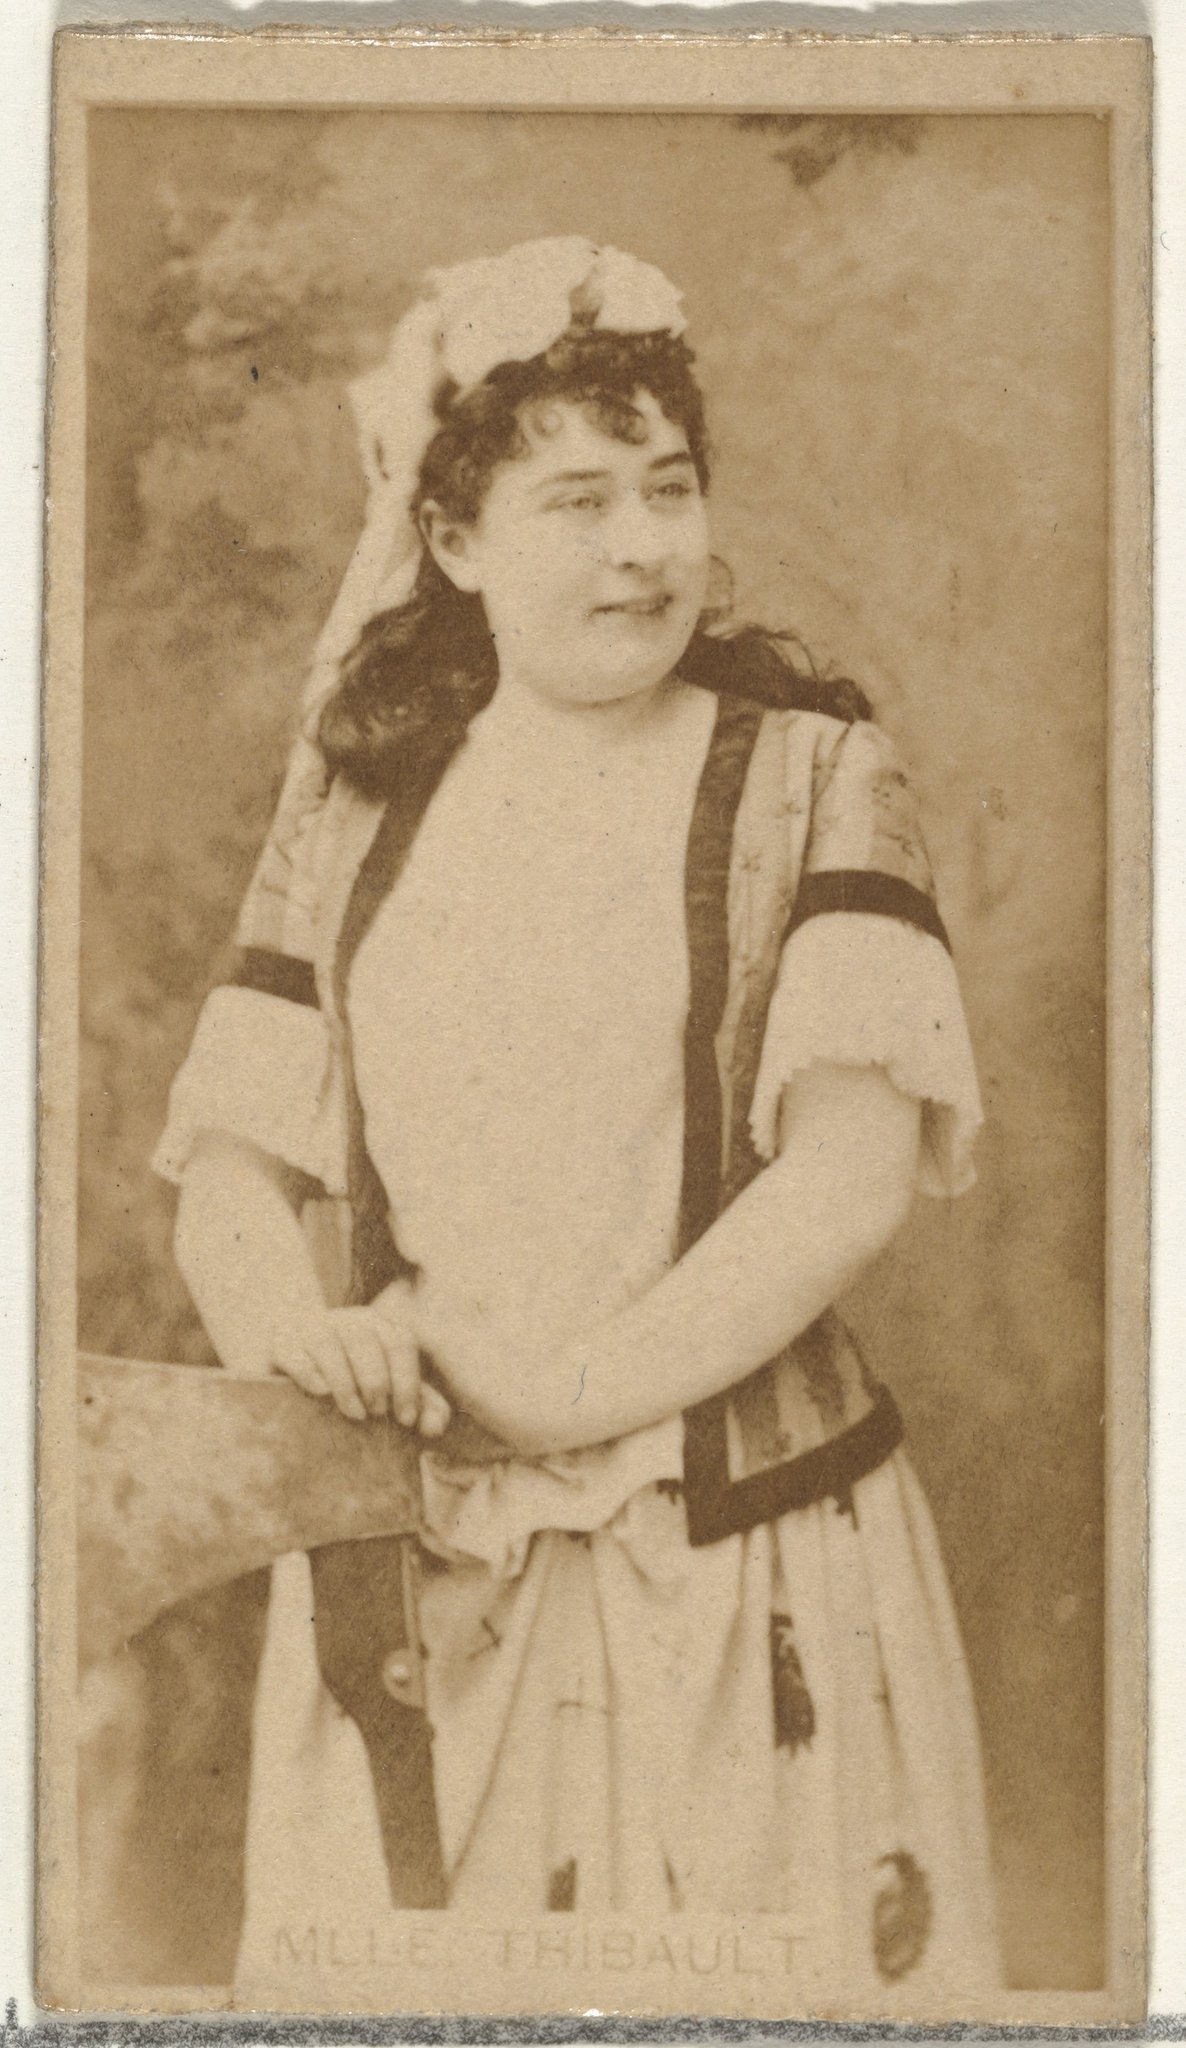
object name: photograph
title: Mlle. Thibault, from the Actors and Actresses series (N145-8) issued by Duke Sons & Co. to promote Duke Cigarettes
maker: w. duke, sons & co.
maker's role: publisher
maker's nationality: american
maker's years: 1870-1920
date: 1891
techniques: albumen silver print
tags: portraits,women,actresses